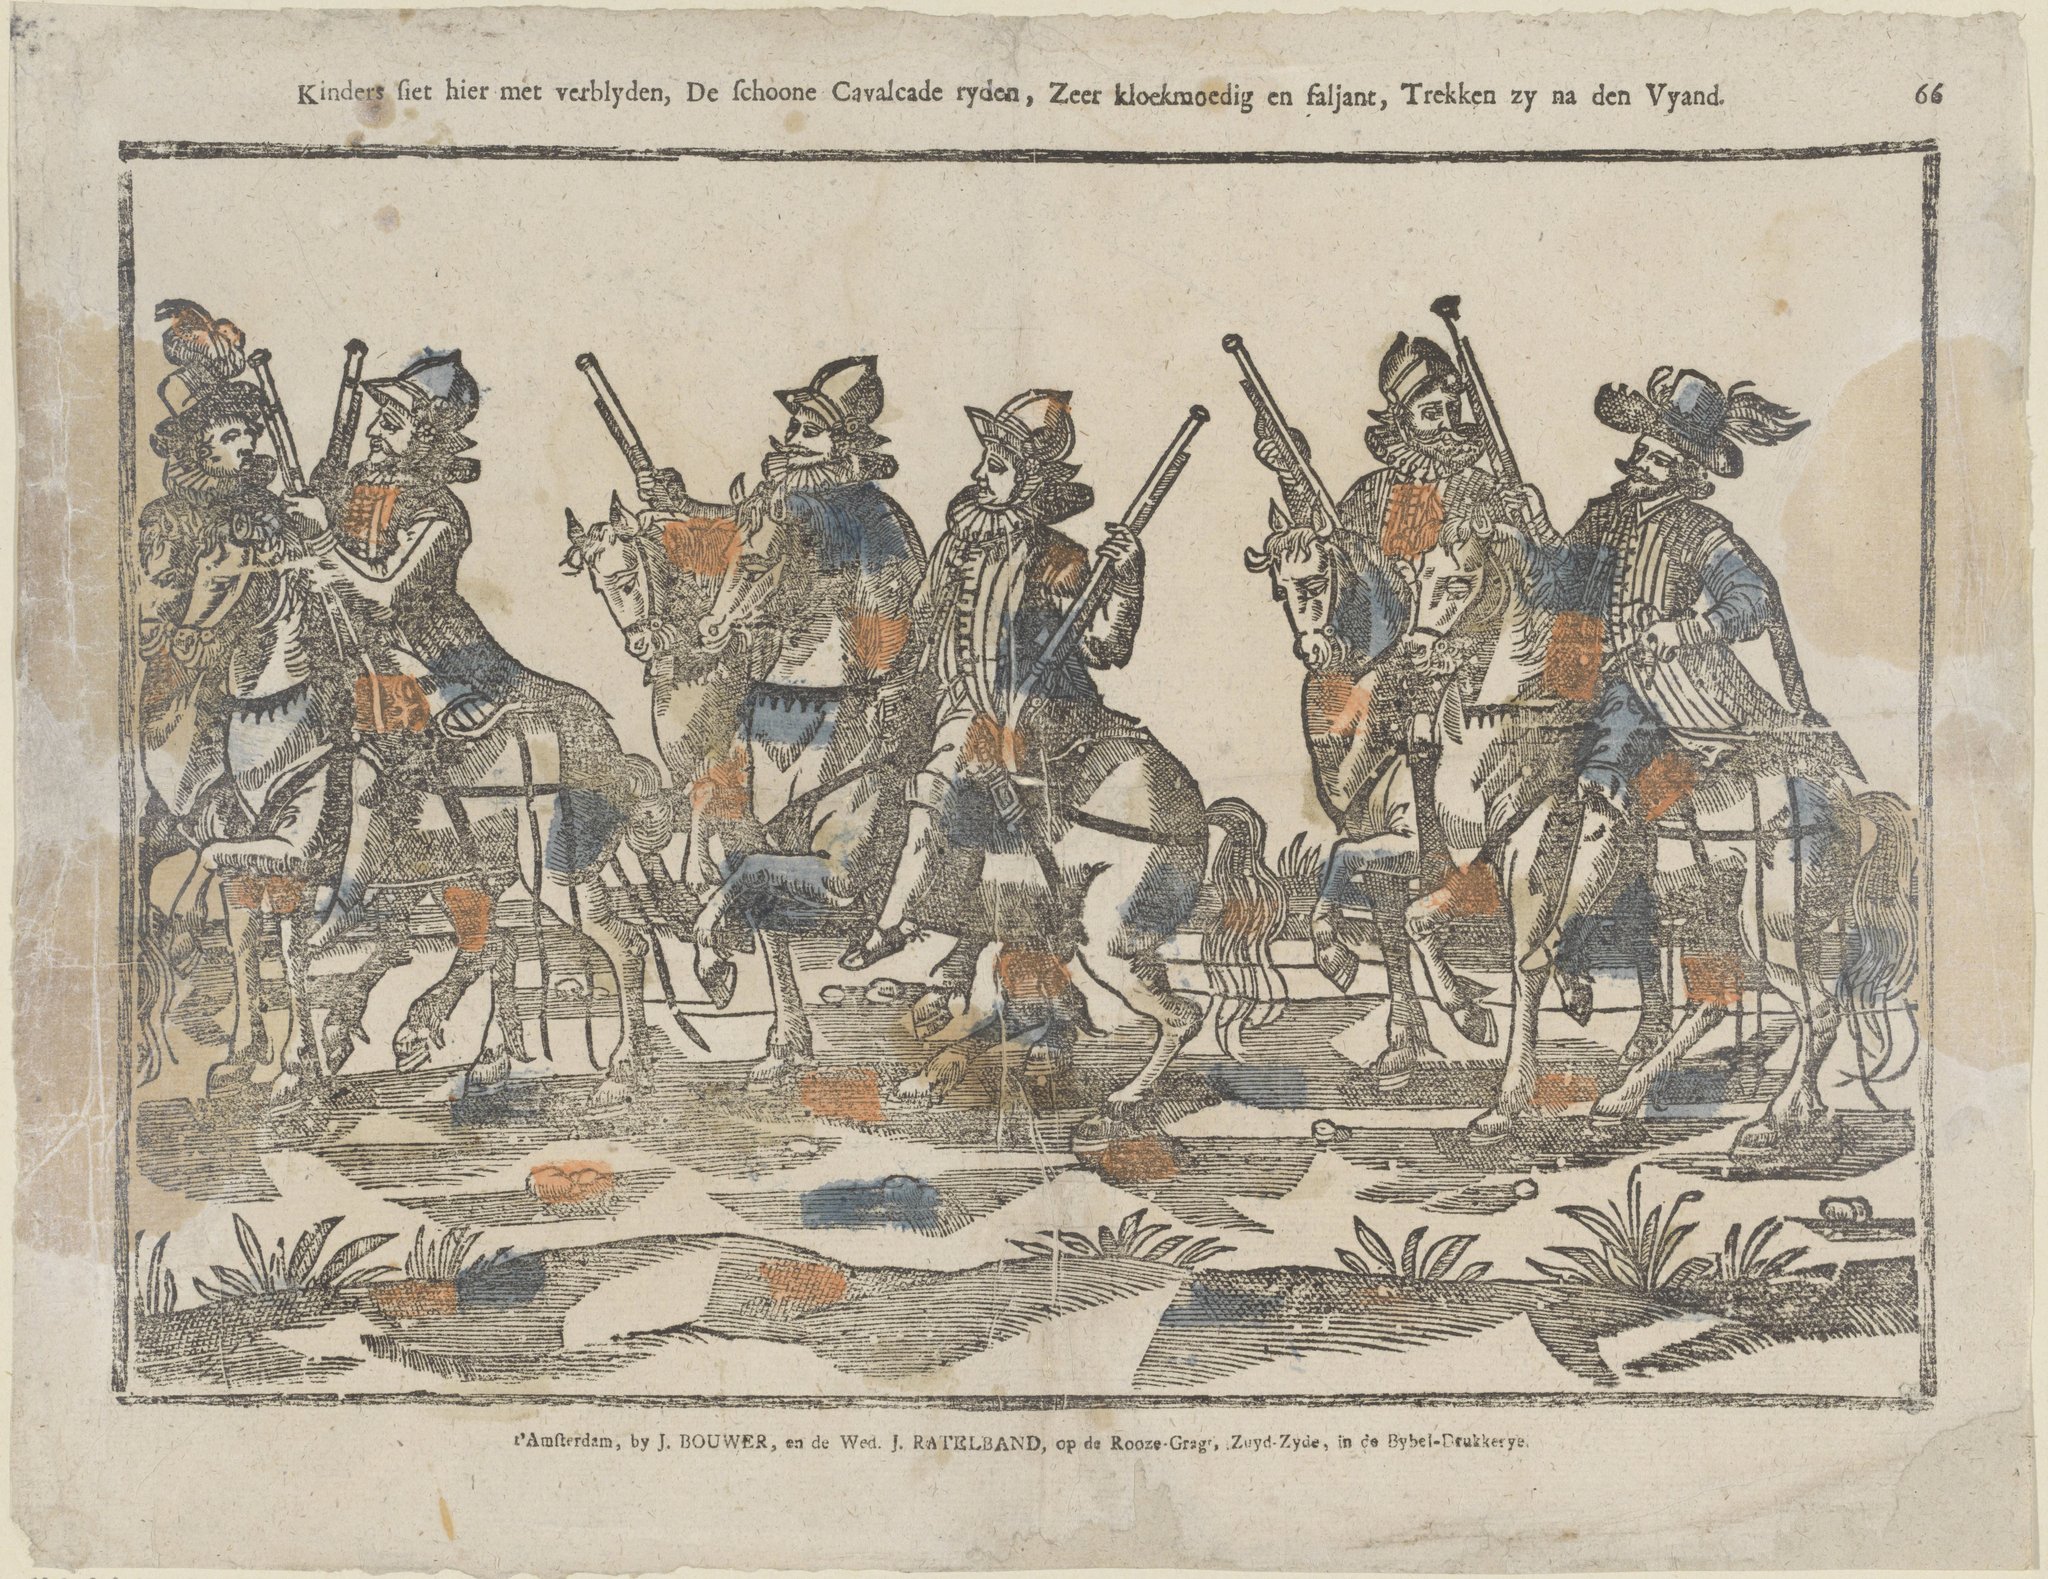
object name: print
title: Kinders siet hier met verblyden, De schoone cavalcade ryden, Zeer kloekmoedig en faljant, trekken zy na den vyand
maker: Anonymous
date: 1794-1804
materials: paper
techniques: colour, letterpress printing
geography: netherlands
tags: warfare; military affairs (+ cavalry, horsemen), the soldier; the soldier's life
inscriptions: collector's mark: Lugt 2760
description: Blad met een grote voorstelling van zes militairen te paard. Genummerd rechtsboven: 66.